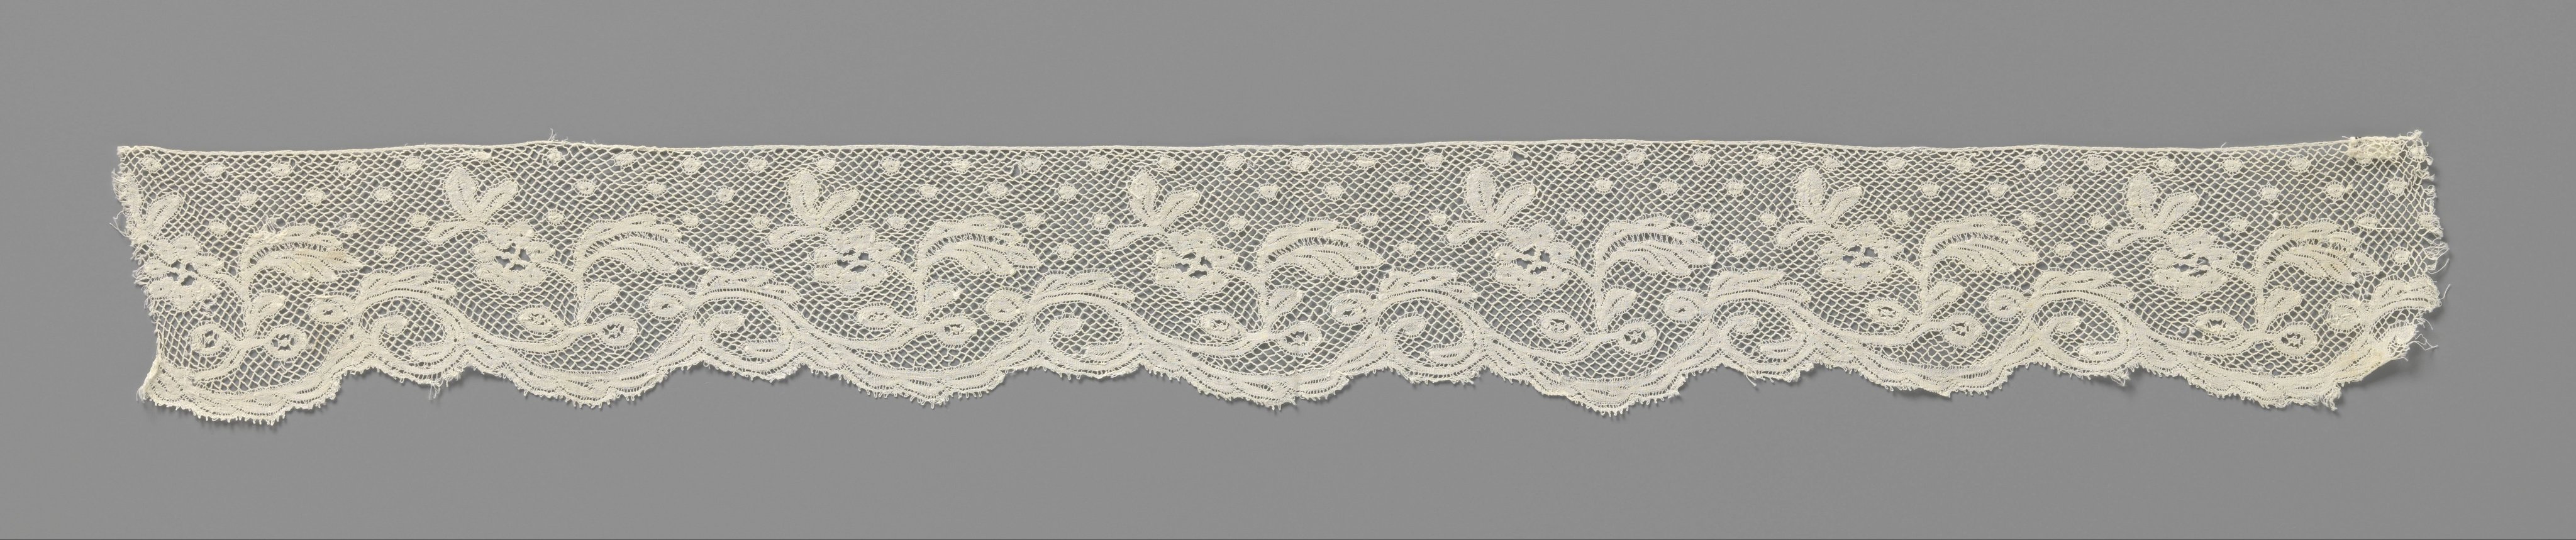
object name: strip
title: Strook kloskant met S-vormig takje en rozetje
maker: Anonymous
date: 1875-1899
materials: linen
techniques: lace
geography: sluis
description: Op een grof en met moesjes bezaaid mazenfond (vierkante maas) staat een S-vormig takje met een rozetje en een groot blad telkens boven een gelobde schulp. Valenciennes-kant.